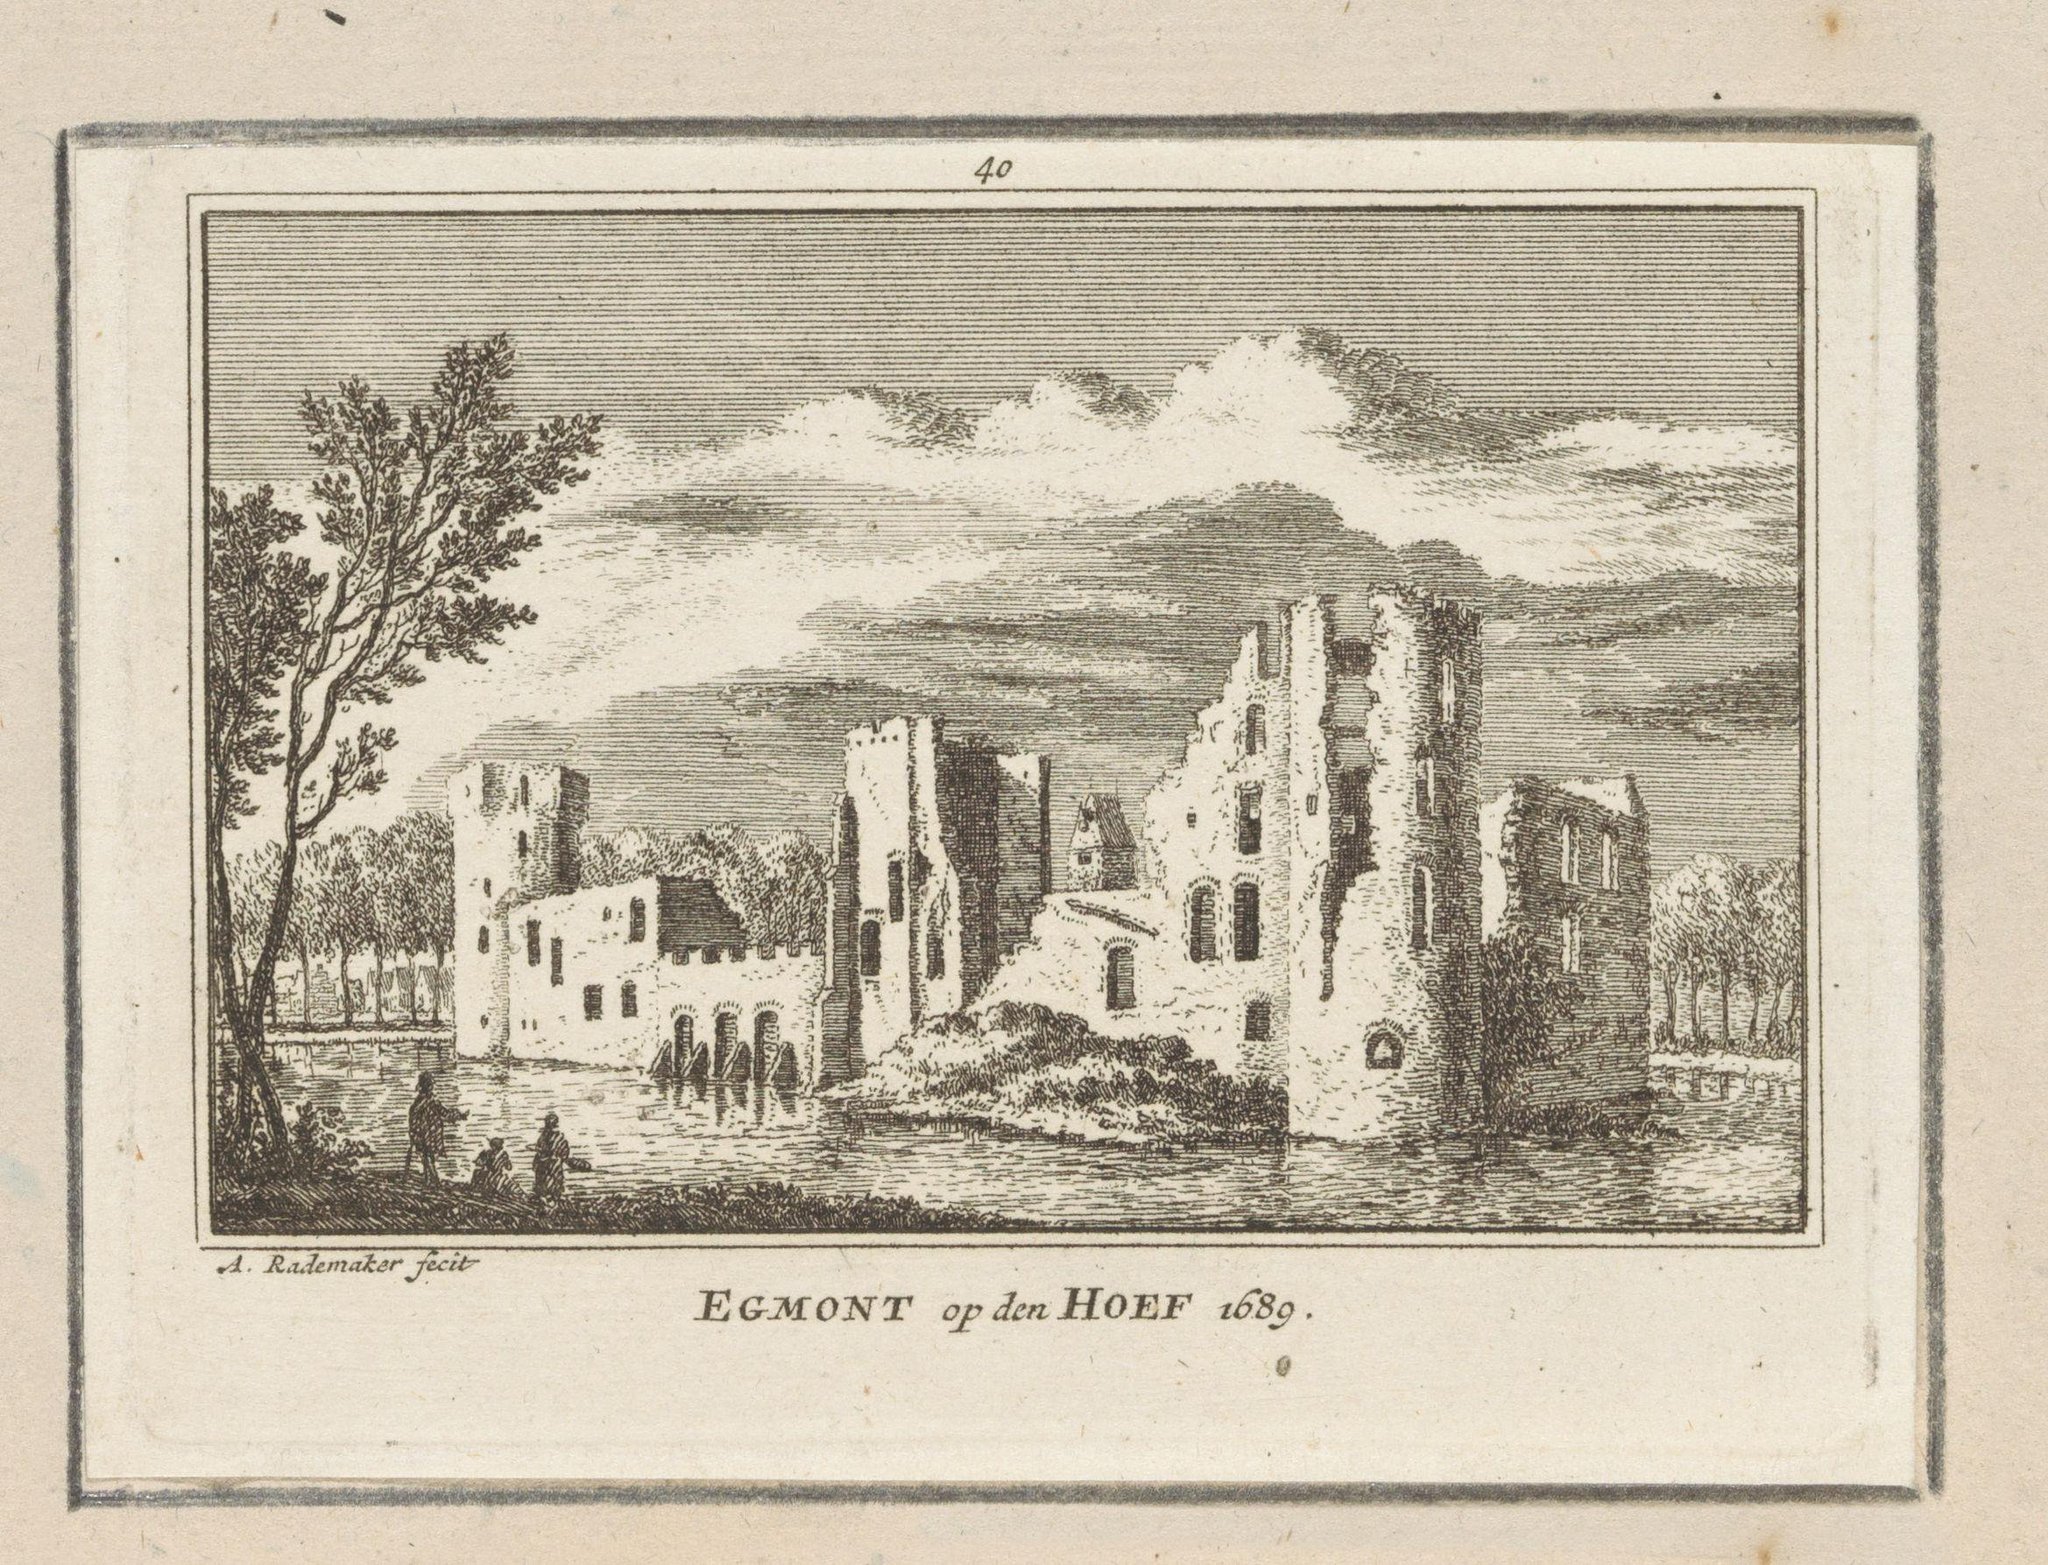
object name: print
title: Egmont op den Hoef 1689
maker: abraham rademaker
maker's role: draughtsman, print maker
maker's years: 1676-1735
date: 1725-1803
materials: paper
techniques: engraving, etching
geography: amsterdam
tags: castle, ruin of a dwelling, house, castle, etc.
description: Prent ook gebruikt in: Rademaker, Abraham. Kabinet van Nederlandsche outheden en gezichten: vervat in 300 konstplaaten (…). 2 delen. Amsterdam: Willem Barents, 1725, dl. 1, ill. 40. Na 1725 is deze prent nog in verschillende heruitgaven verschenen, uitgegeven in 1727-1733, 1770-1771 en 1792-1803. Uit welke uitgave het huidige exemplaar precies komt is niet na te gaan.